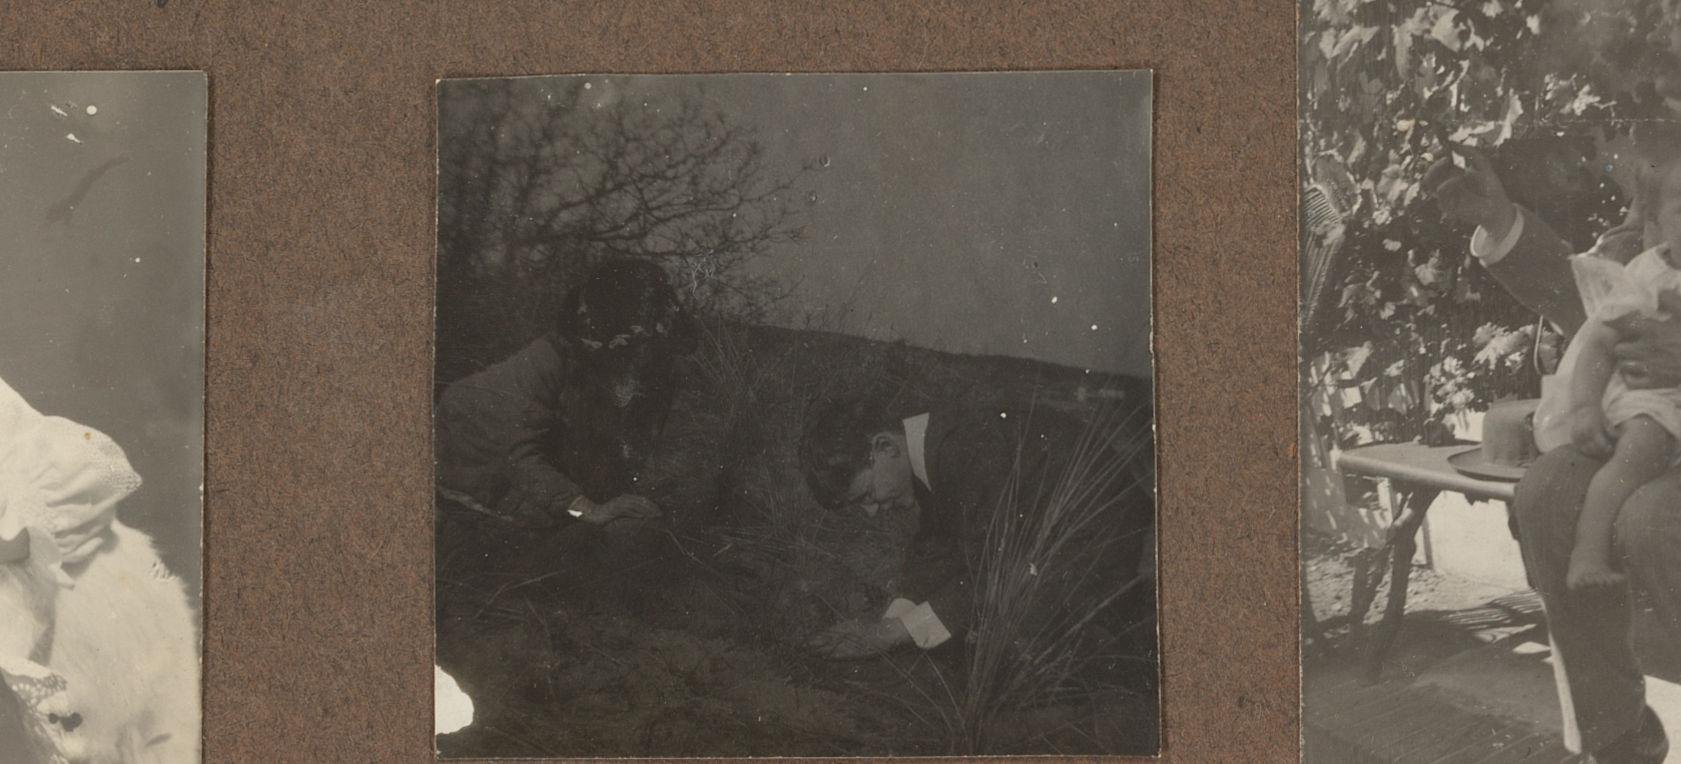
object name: photograph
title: Hilda en Jan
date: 1880-1920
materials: photographic support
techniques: photography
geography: amsterdam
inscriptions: inscription: ‘Hilda en Jan’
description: Foto op bruin albumblad 26 van familiealbum van Alphons Diepenbrock.